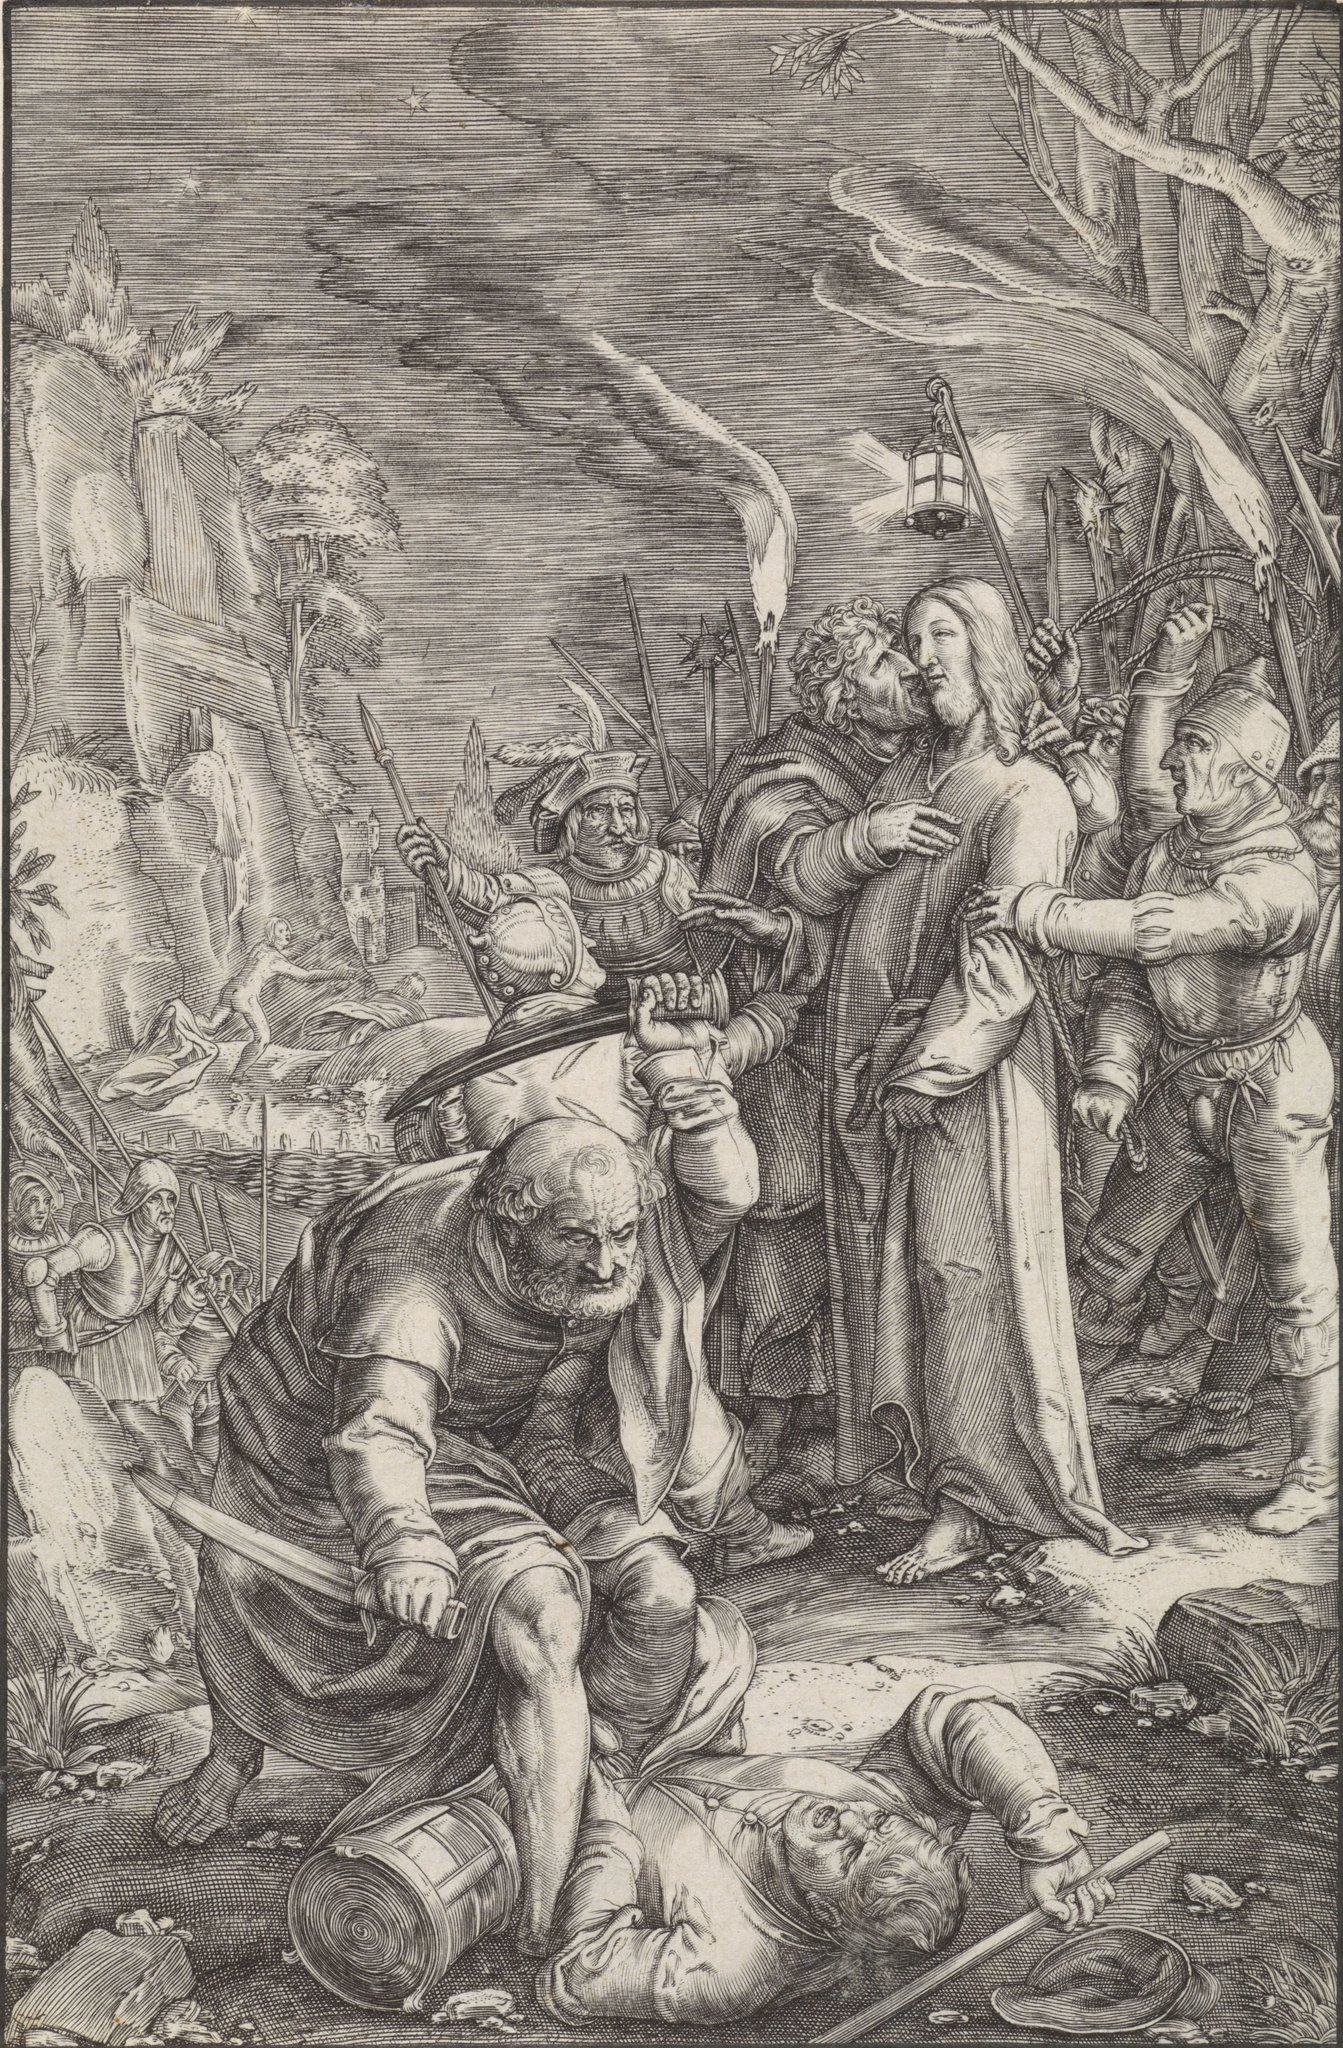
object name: print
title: De Passie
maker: ludovicus siceram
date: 1623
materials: paper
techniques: engraving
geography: antwerp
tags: peter draws his sword and cuts off malchus' ear, the kiss of judas: accompanied by soldiers with torches and lanterns, he kisses christ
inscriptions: collector's mark: Lugt 2228a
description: Christus wordt door soldaten gevangen genomen in de hof van Getsemane. Judas kust hem op de wang. Op de voorgrond hakt Petrus Malchus een oor af.